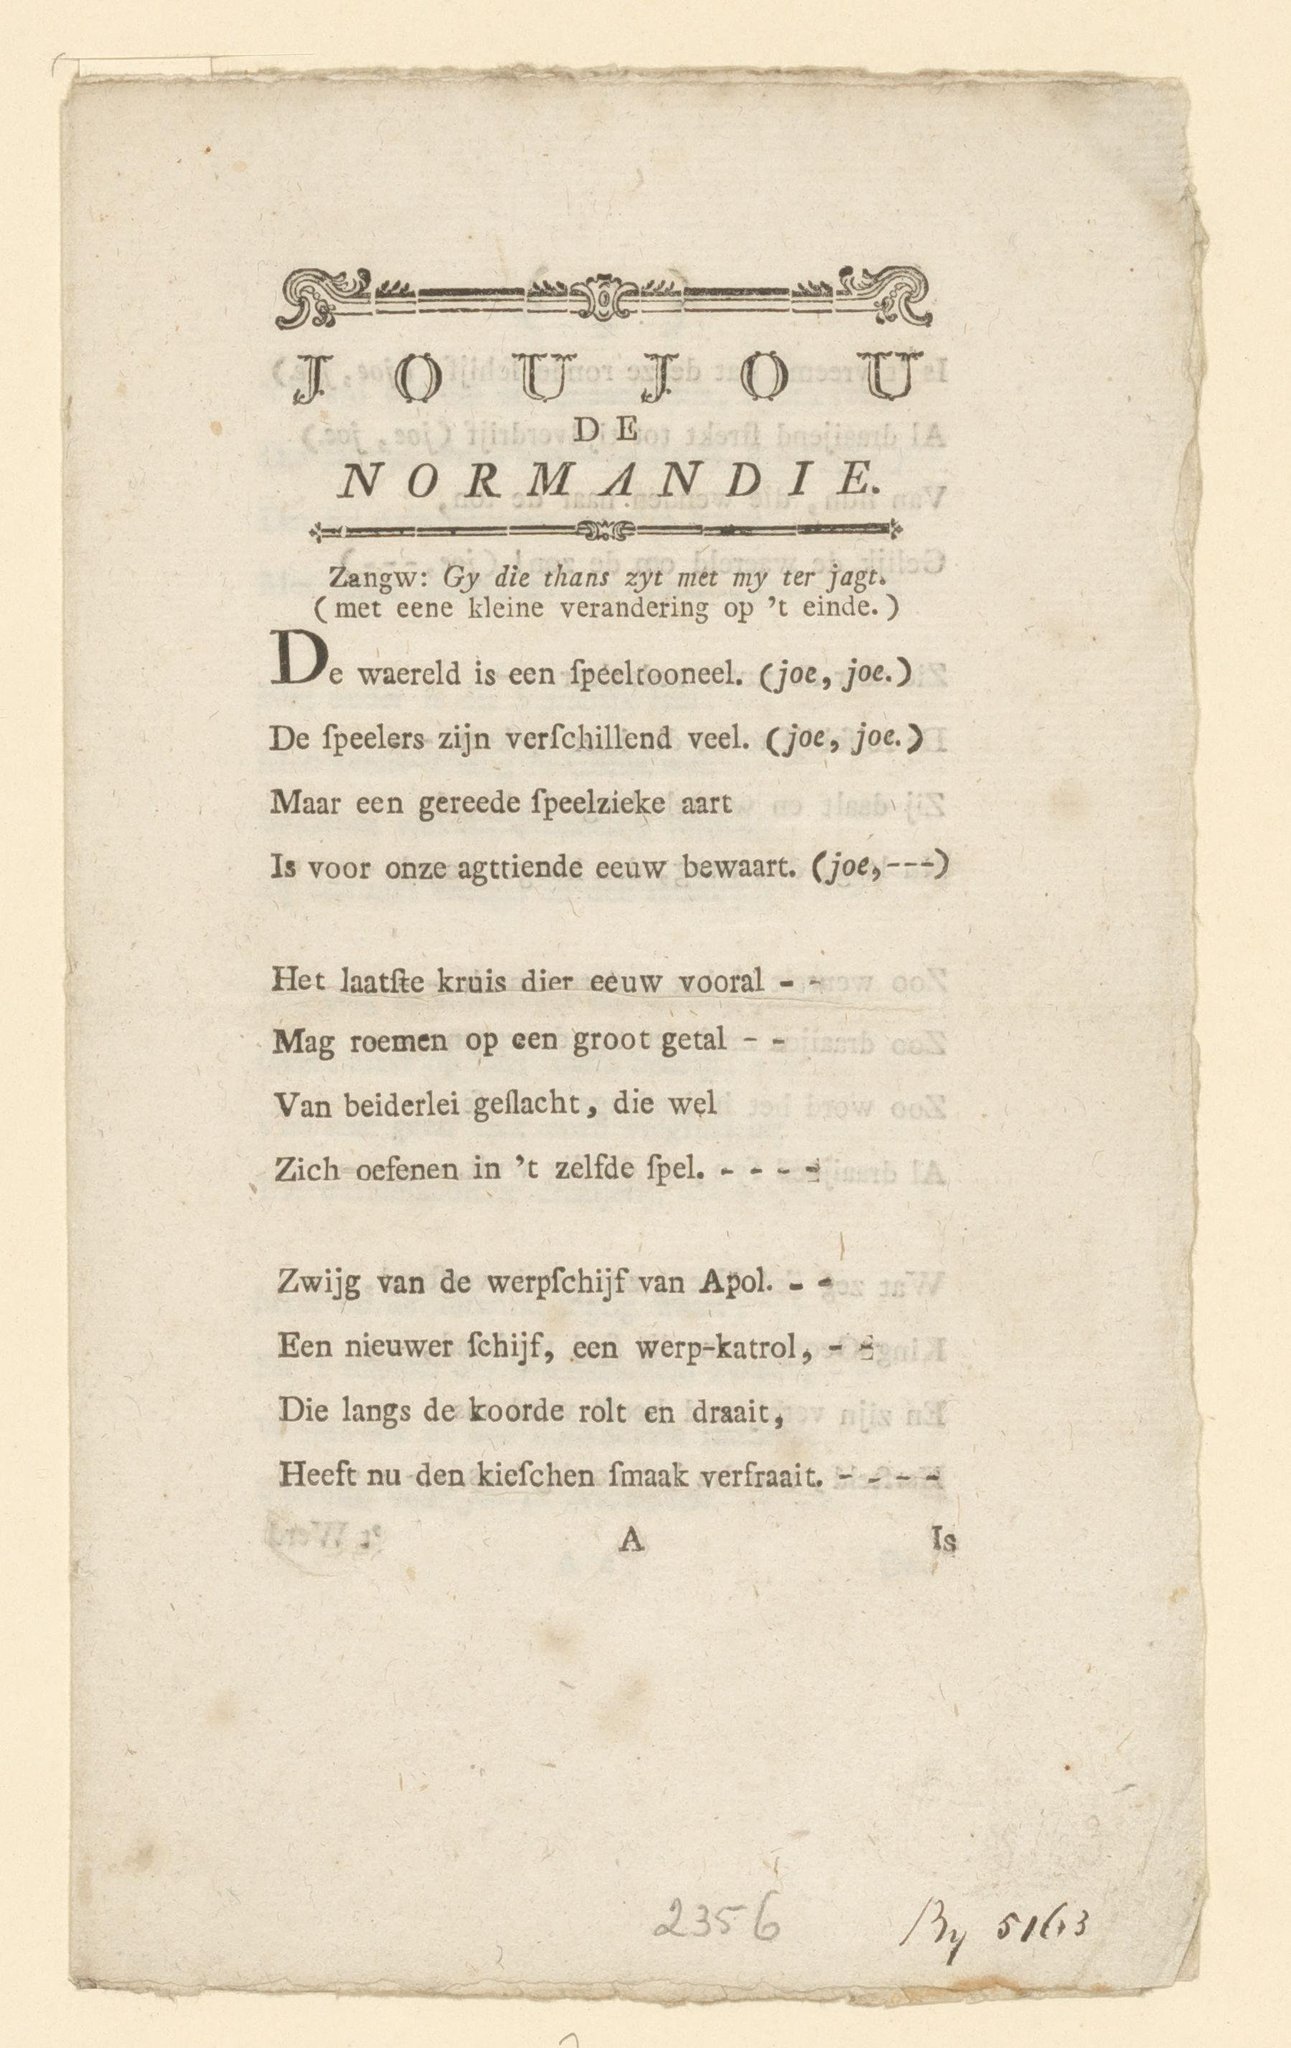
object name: brochure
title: Joujou de Normandie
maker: Anonymous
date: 1791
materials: paper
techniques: letterpress printing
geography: netherlands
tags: yoyo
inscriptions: collector's mark, collector's mark: Lugt 1641